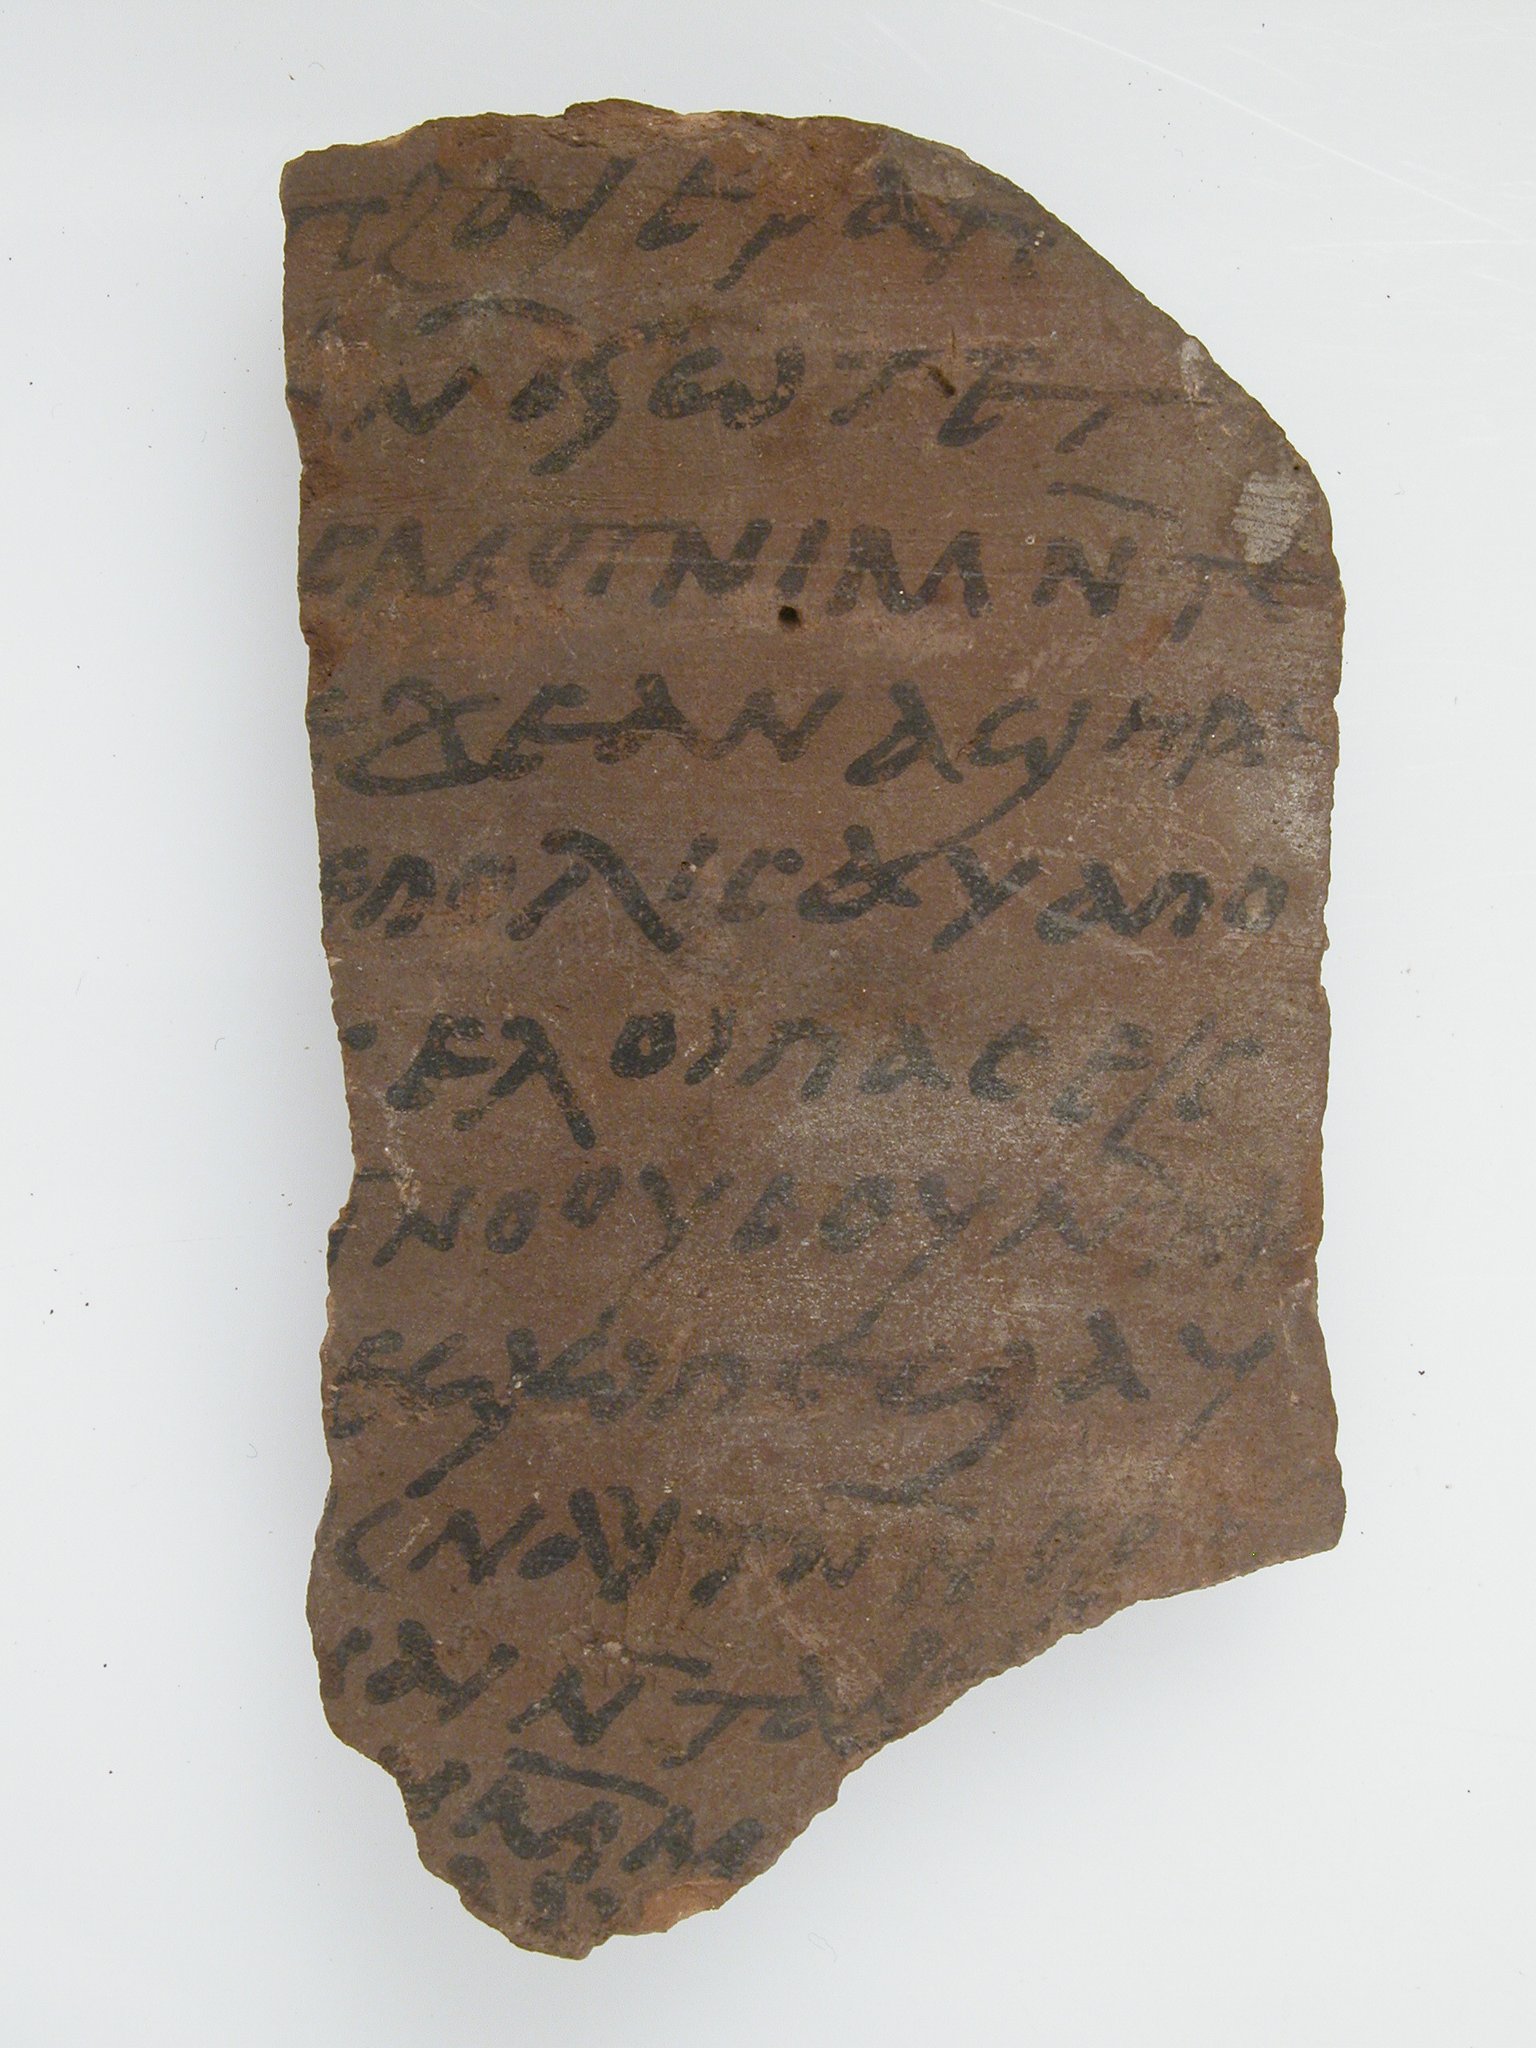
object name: ostrakon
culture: coptic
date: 601-700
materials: ink, pottery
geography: egypt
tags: coptic